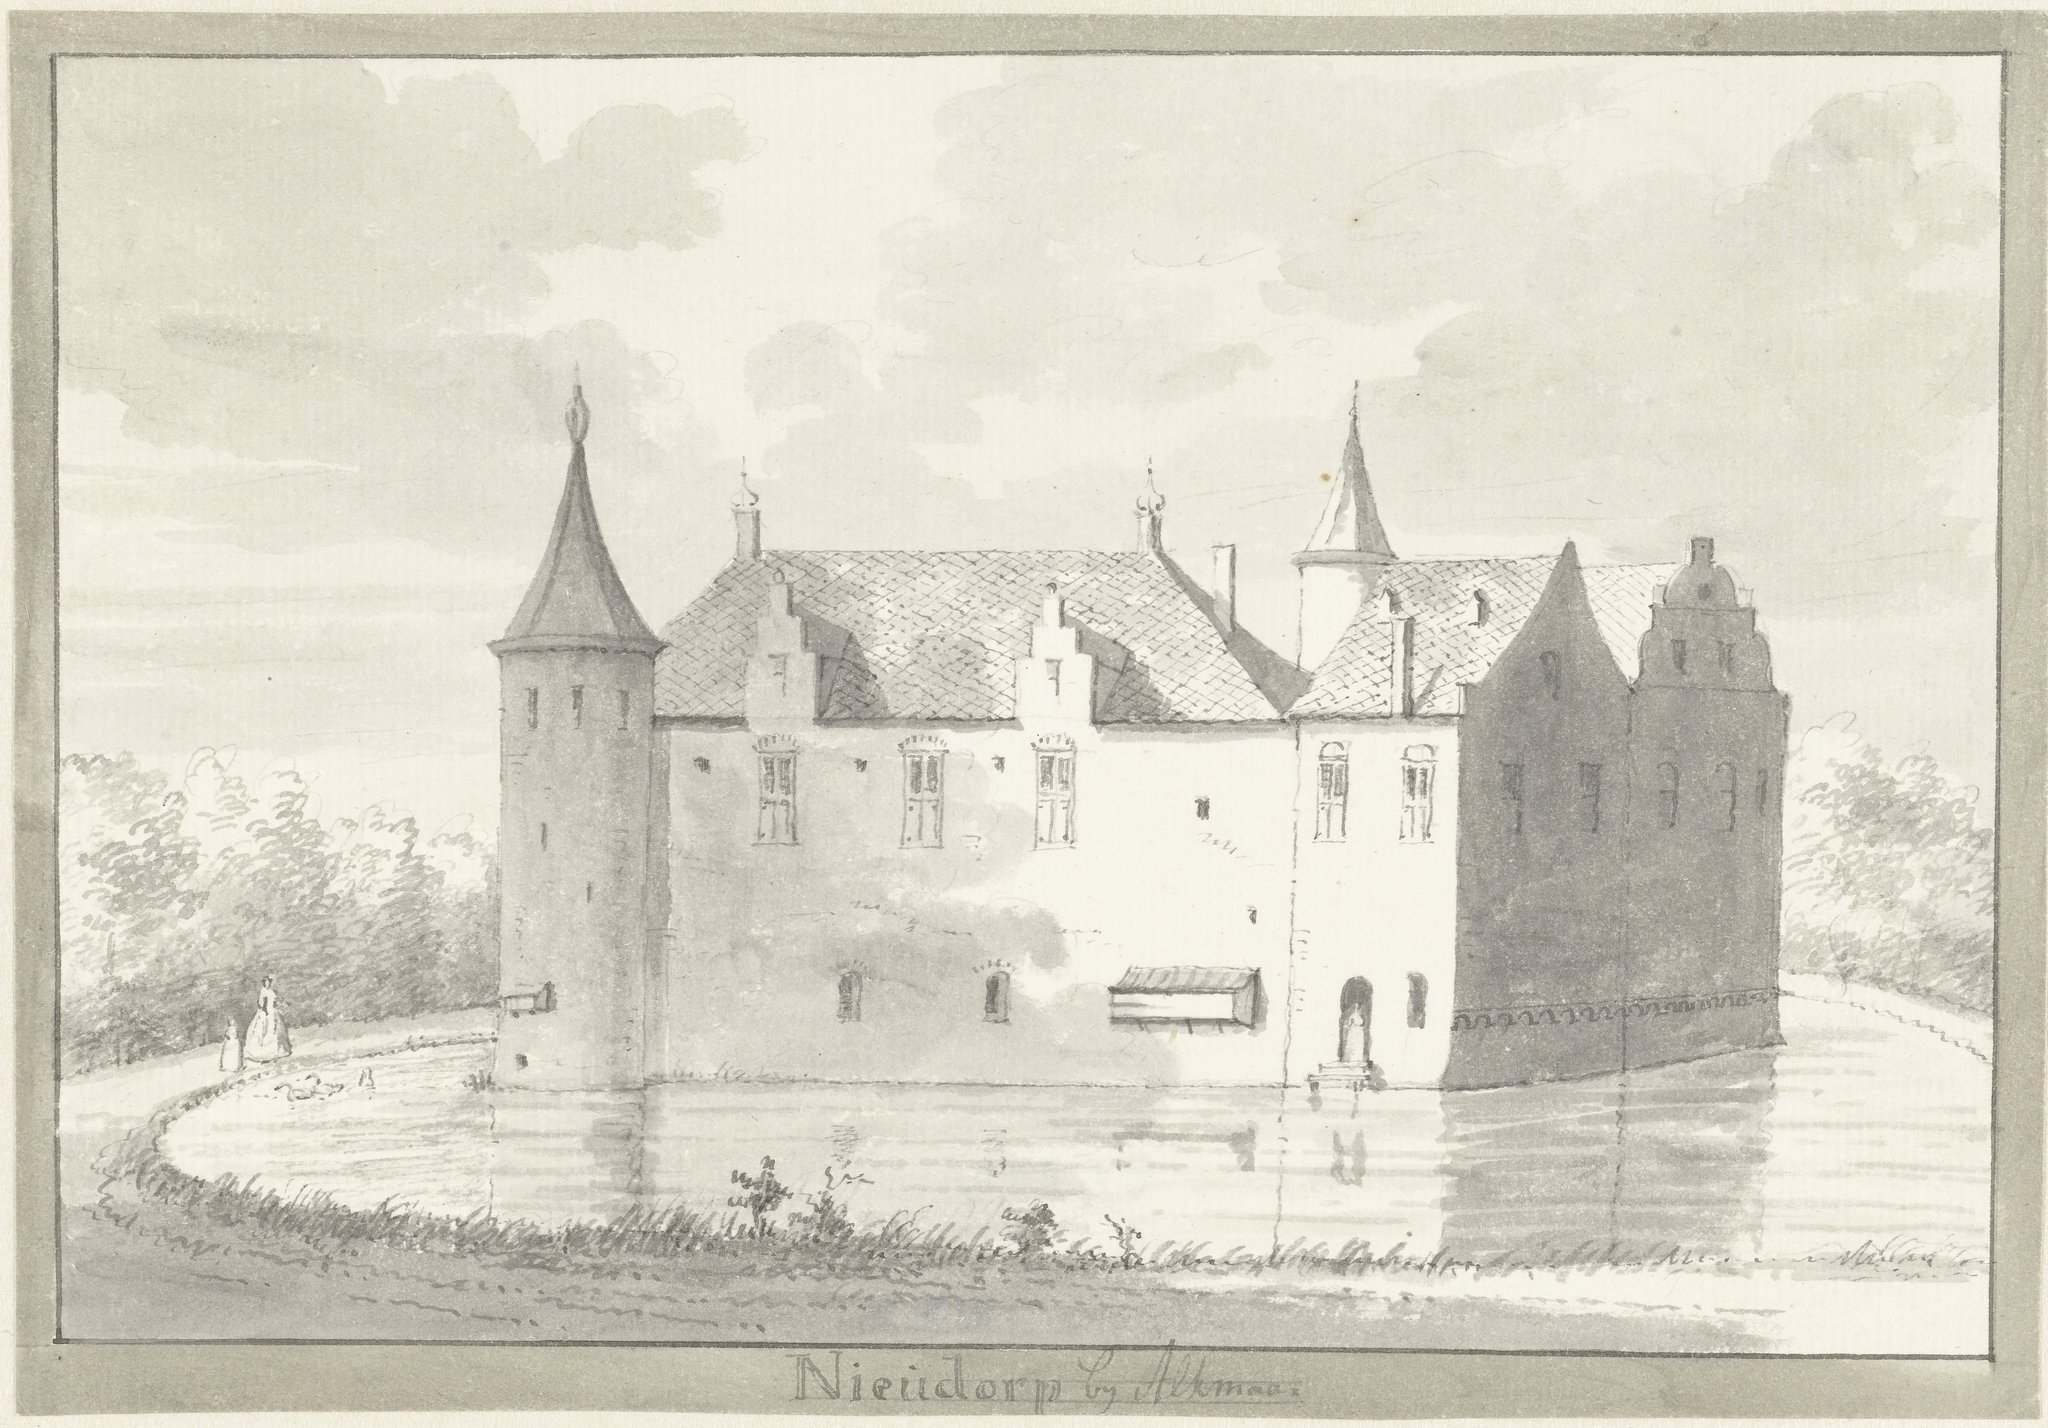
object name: drawing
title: Kasteel Nieudorp bij Alkmaar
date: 1727-1790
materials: ink, paper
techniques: brush, pen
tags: castle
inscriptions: inscription: ‘Nieudorp by Alkmaar’